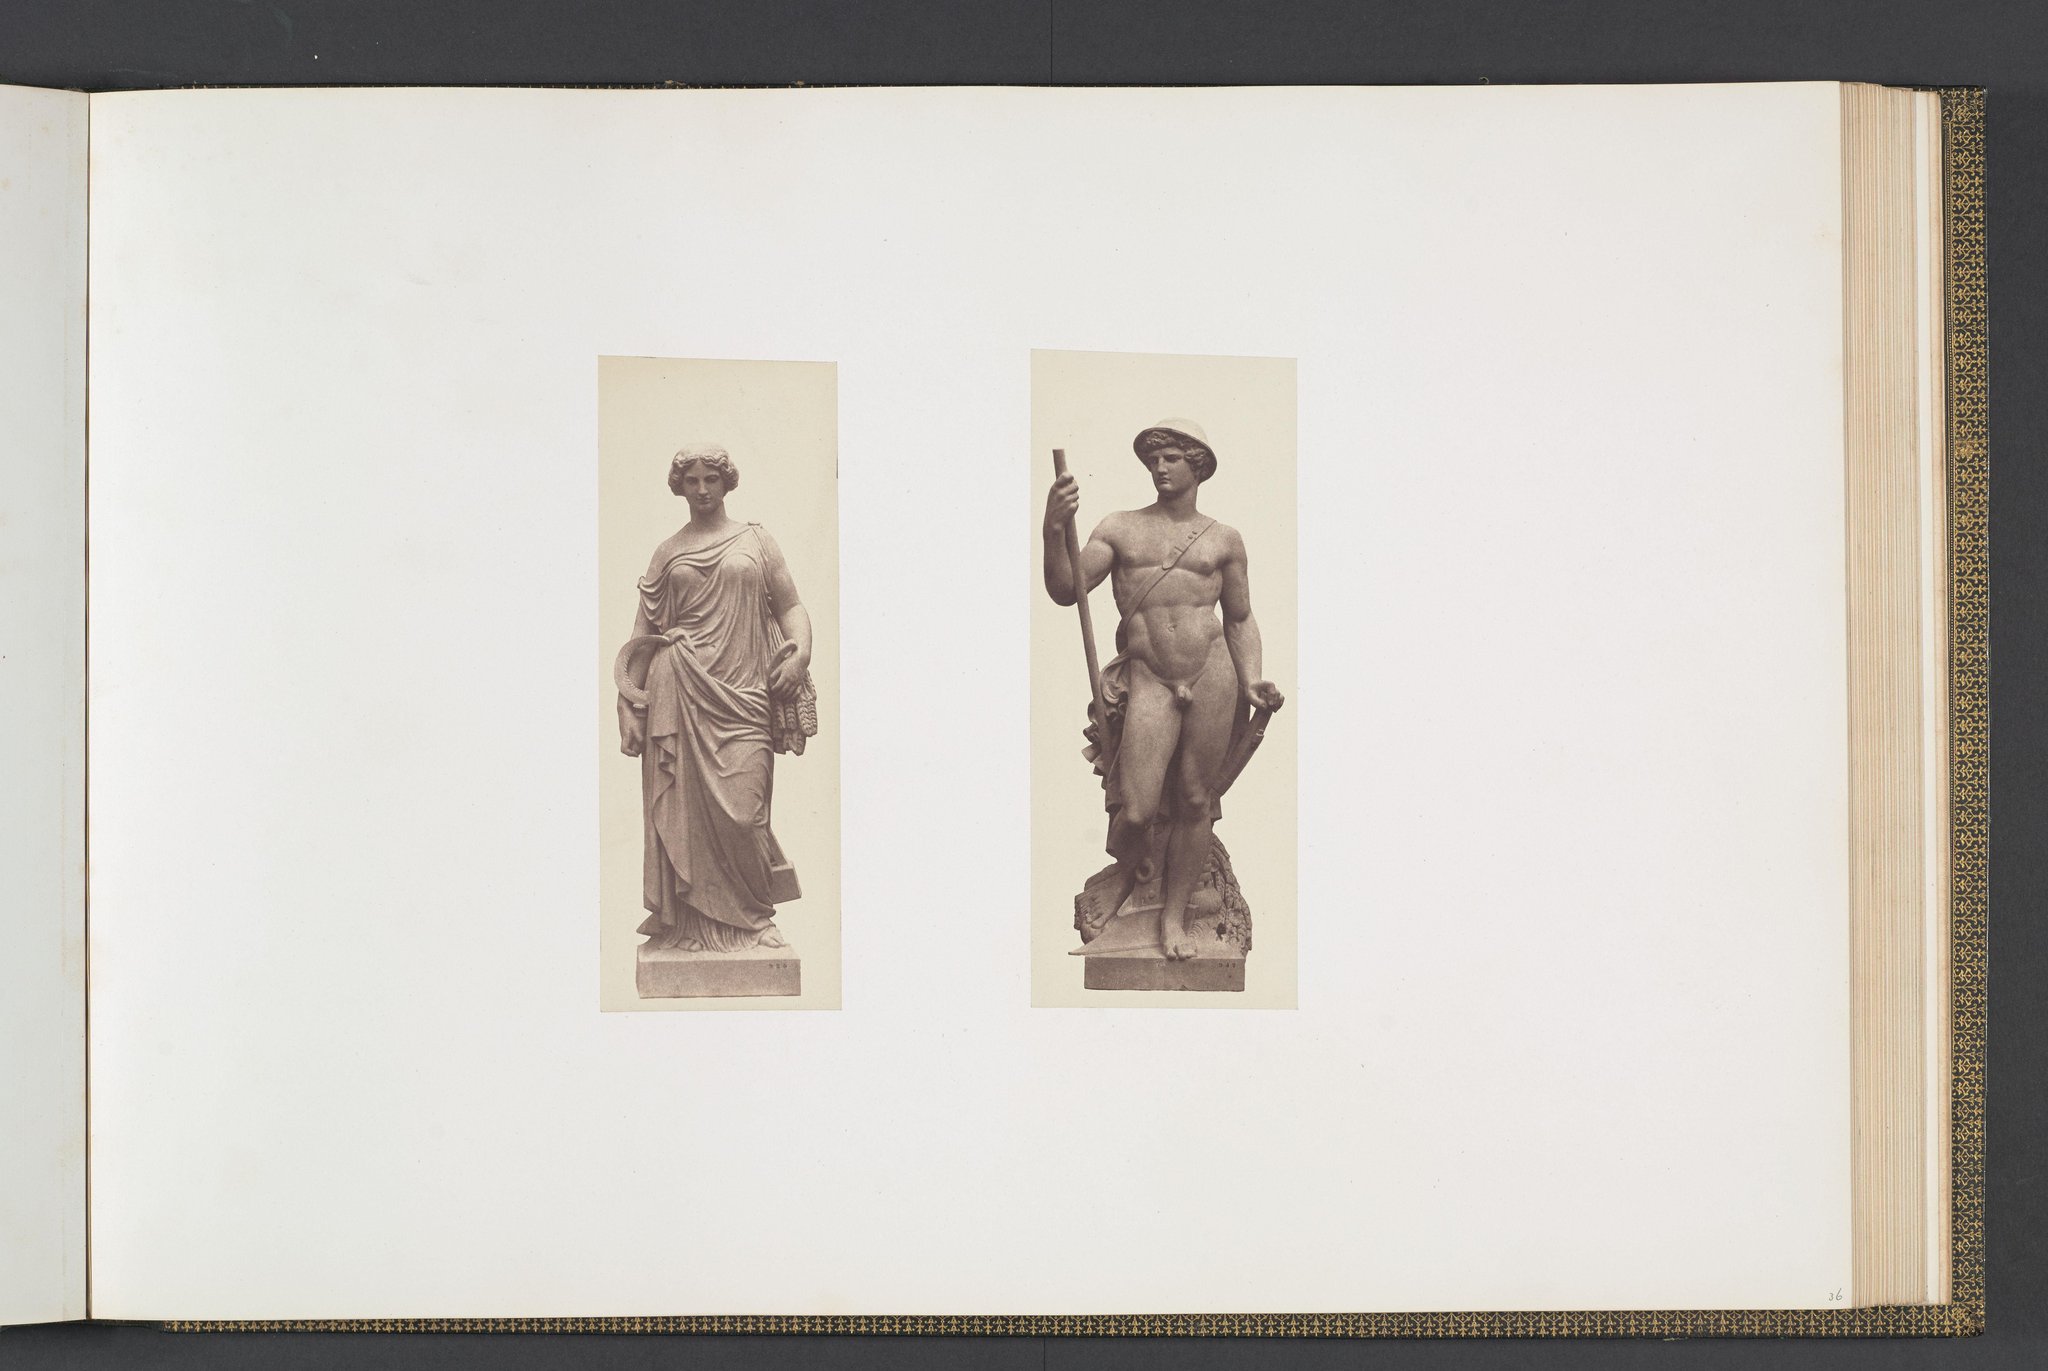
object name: album leaf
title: Gipsmodellen voor beeldhouwwerken op het Palais du Louvre: links "L'Agriculture" door Pierre Loison en rechts "Le Laboureur" door Jean Claude Petit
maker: édouard denis baldus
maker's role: fotograaf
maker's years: 1813-1889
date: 1855-1857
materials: paper, photographic support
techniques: salted paper print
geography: paris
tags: piece of sculpture, reproduction of a piece of sculpture, permanent exhibition, museum, paris, tuileries palace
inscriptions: number: ‘925 en 942’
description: Onderdeel van Réunion des Tuileries au Louvre 1852-1857, album 3.